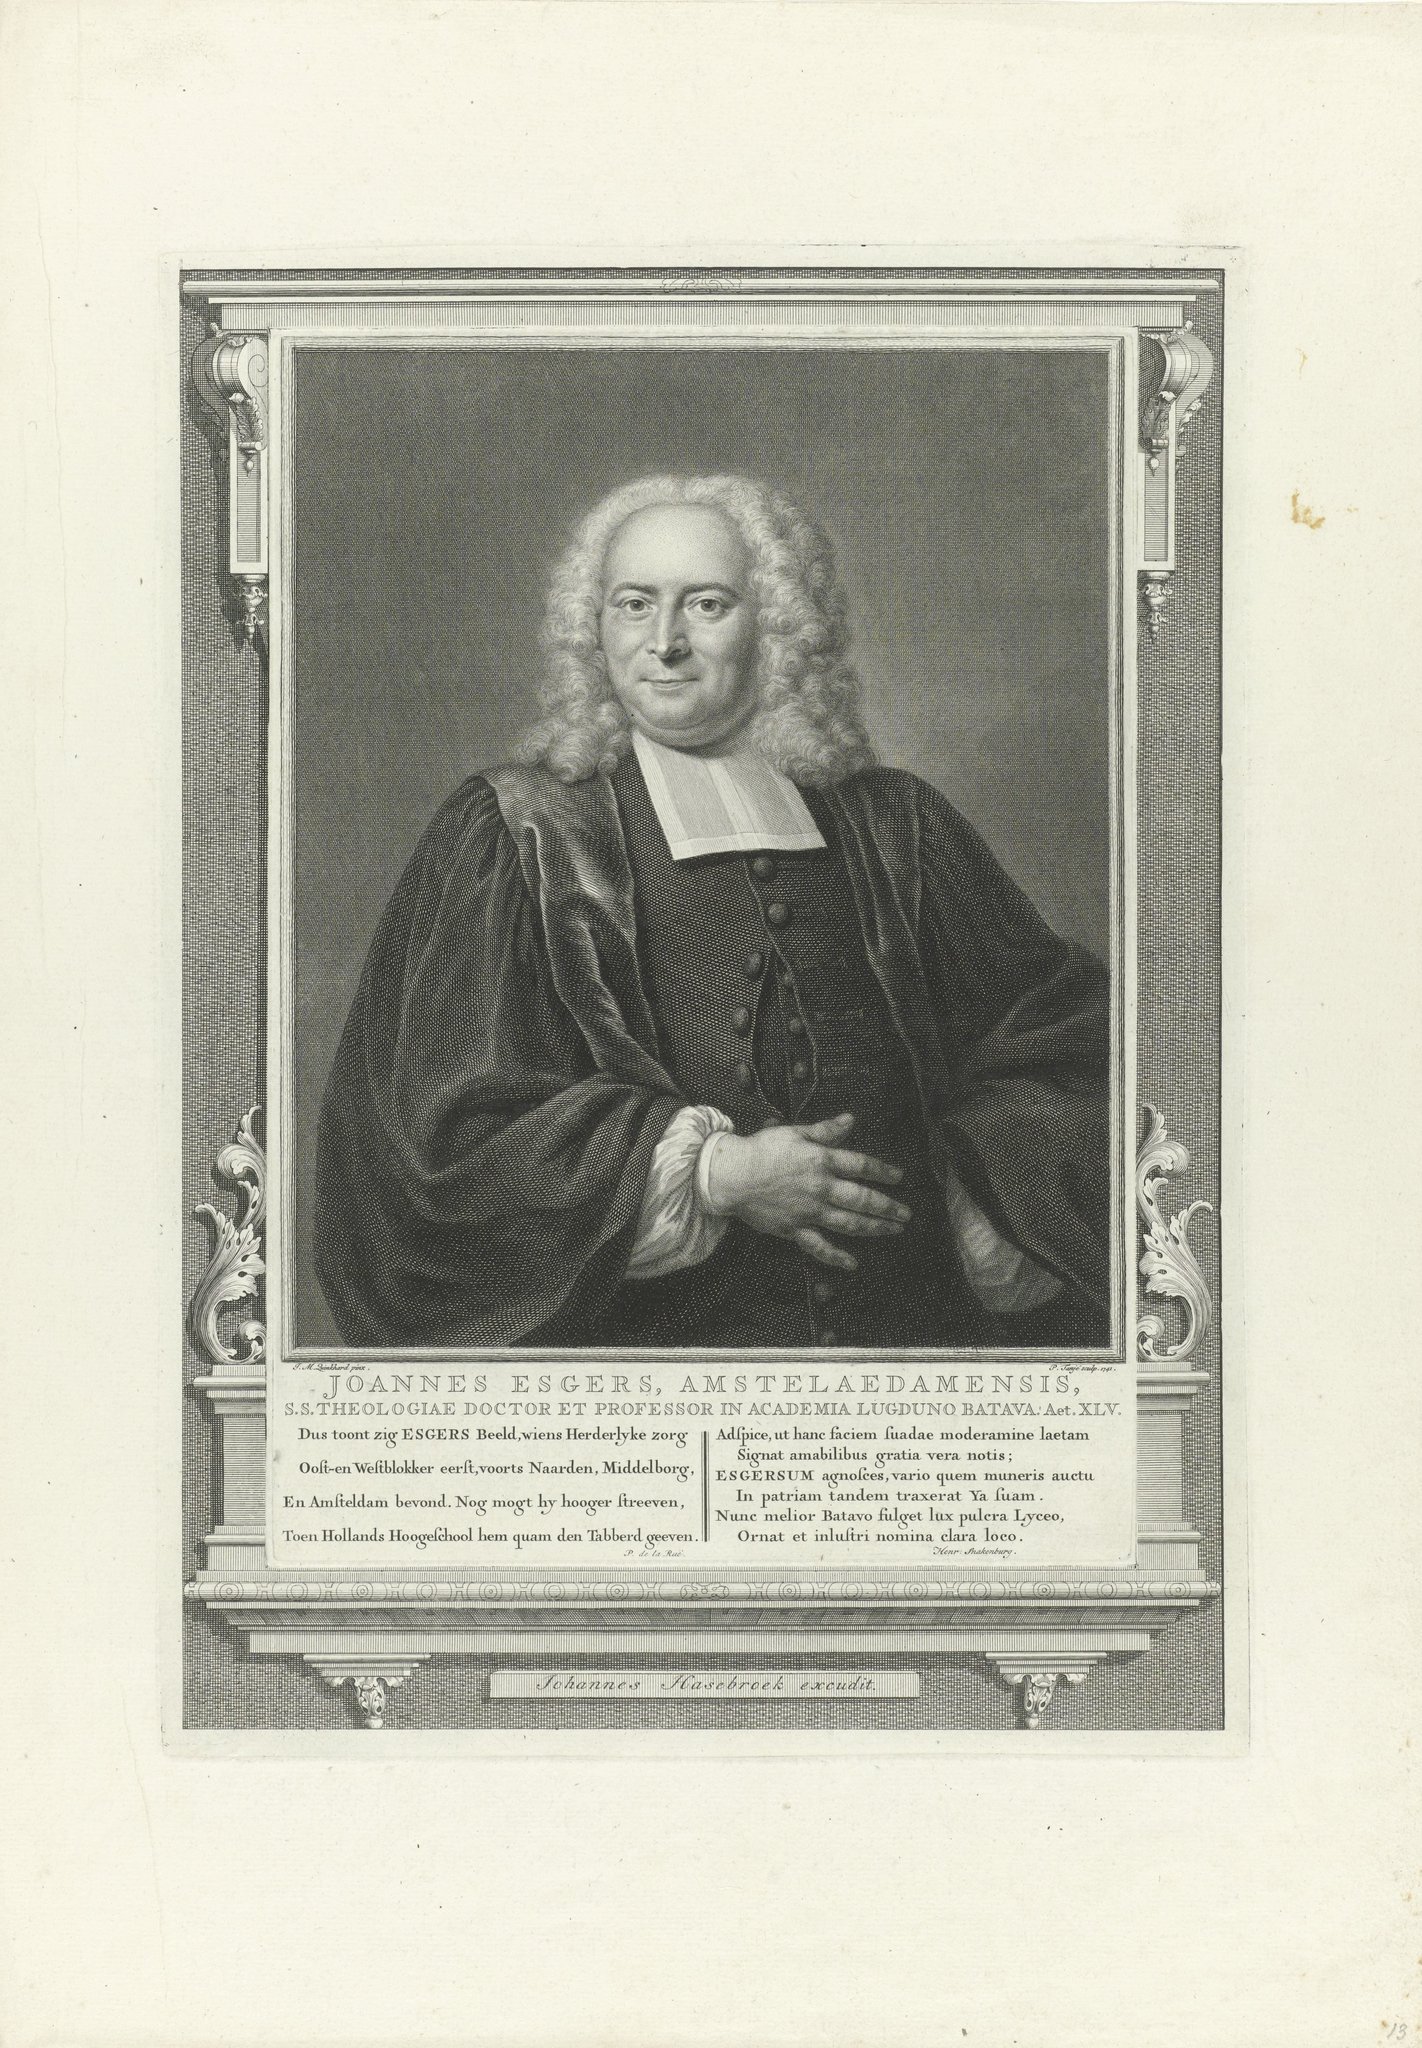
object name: print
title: Portret van Johannes Esgers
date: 1741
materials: paper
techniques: engraving, etching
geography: amsterdam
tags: amsterdam, leiden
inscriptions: collector's mark: Lugt 240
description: Portret van Johannes Esgers. Hij was achtereenvolgens predikant te Ooster- en Westerblokker, Naarden, Middelburg en Amsterdam en tot slot hoogleraar te Leiden. Onder het portret een vierregelig vers in het Nederlands en het Latijn. Het portret en de tekst zijn gevat in een ornamentele randlijst.